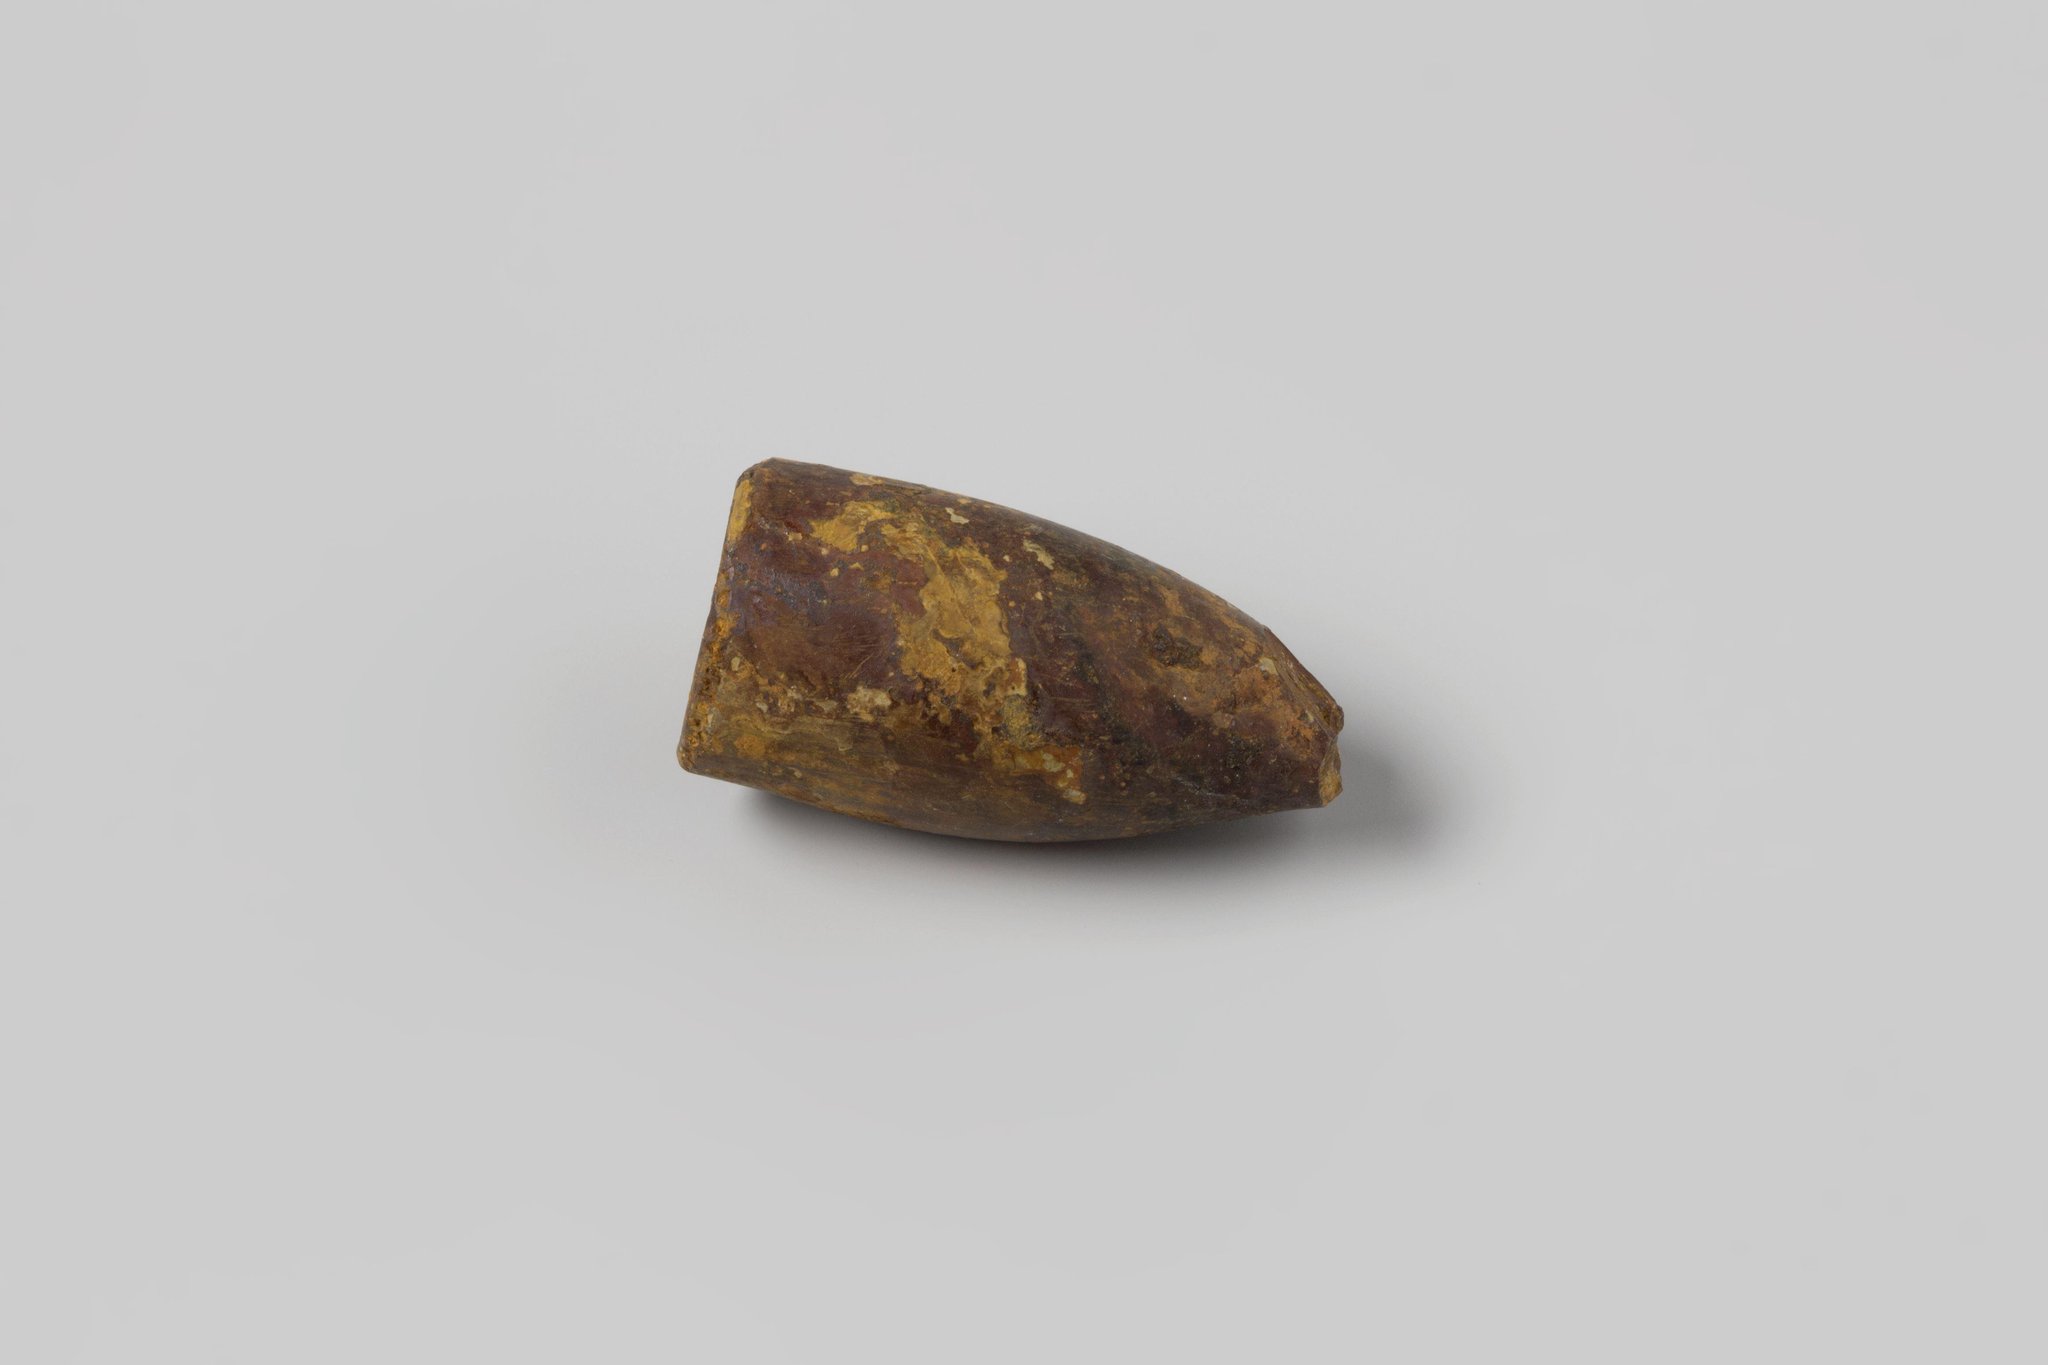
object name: pipe bowl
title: Fragment pijpenkop uit het wrak van de Oost-Indiëvaarder Hollandia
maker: Anonymous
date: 1700-1743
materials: clay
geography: netherlands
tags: verenigde oostindische compagnie, hollandia (schip), annet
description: Pipe, bowl, heelmark illegible; fragment.